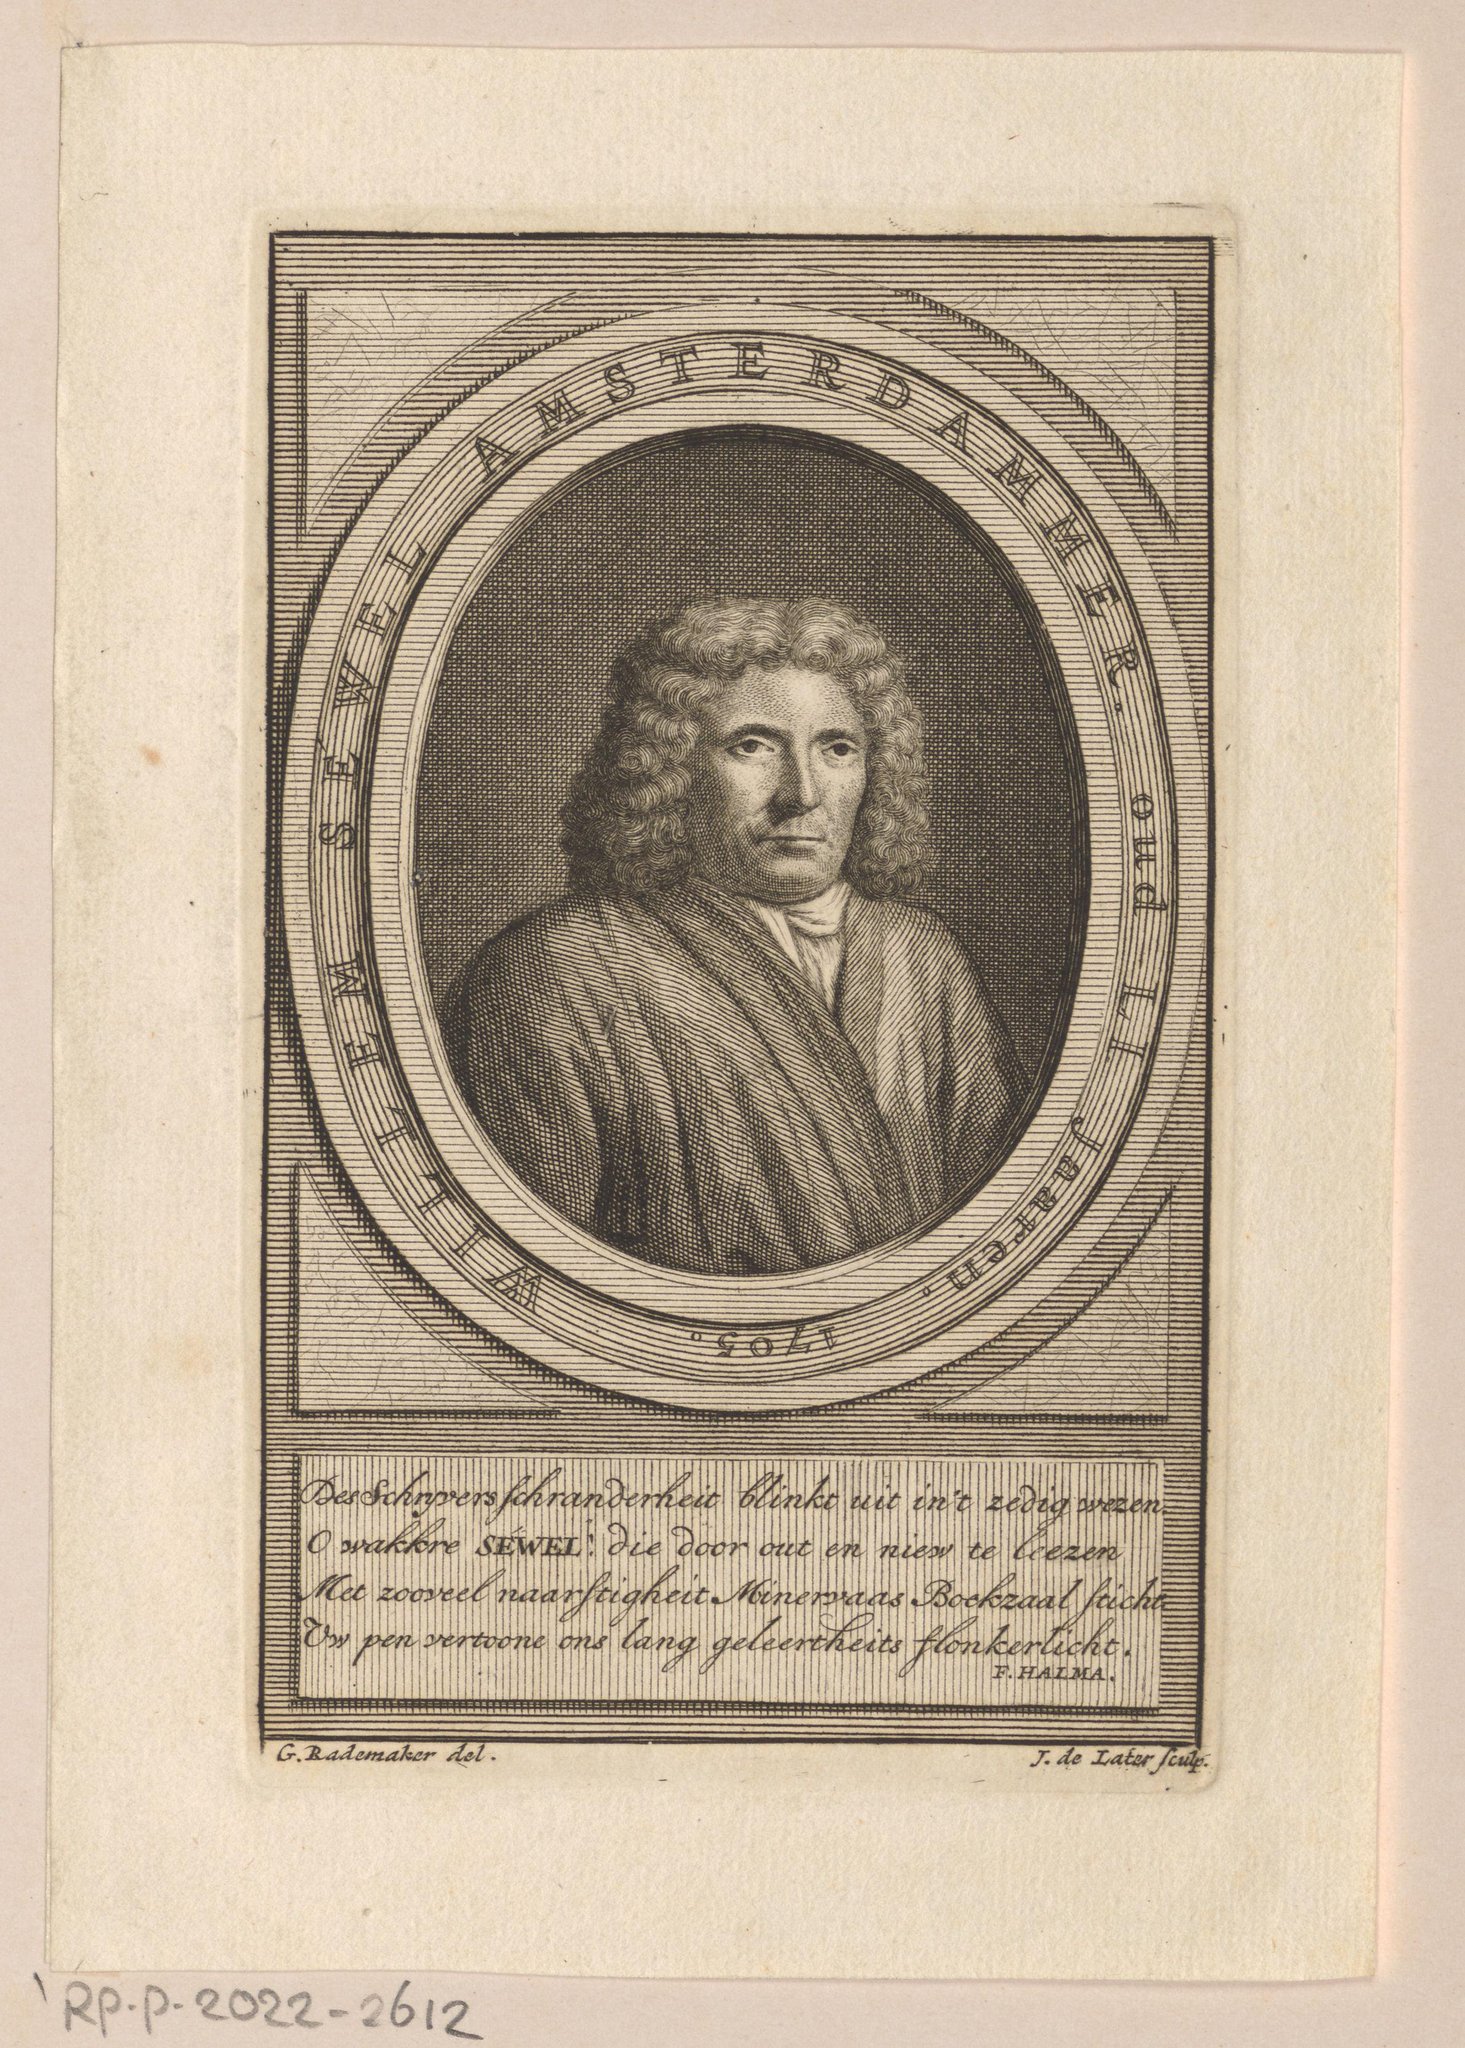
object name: print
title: Portret van Willem Sewel op 51-jarige leeftijd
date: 1705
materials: paper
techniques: engraving, etching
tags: linguistics (+ portrait of scholar, scientist), historical persons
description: Met vierregelig onderschrift in het Nederlands en tekst in het Nederlands rondom het portret.